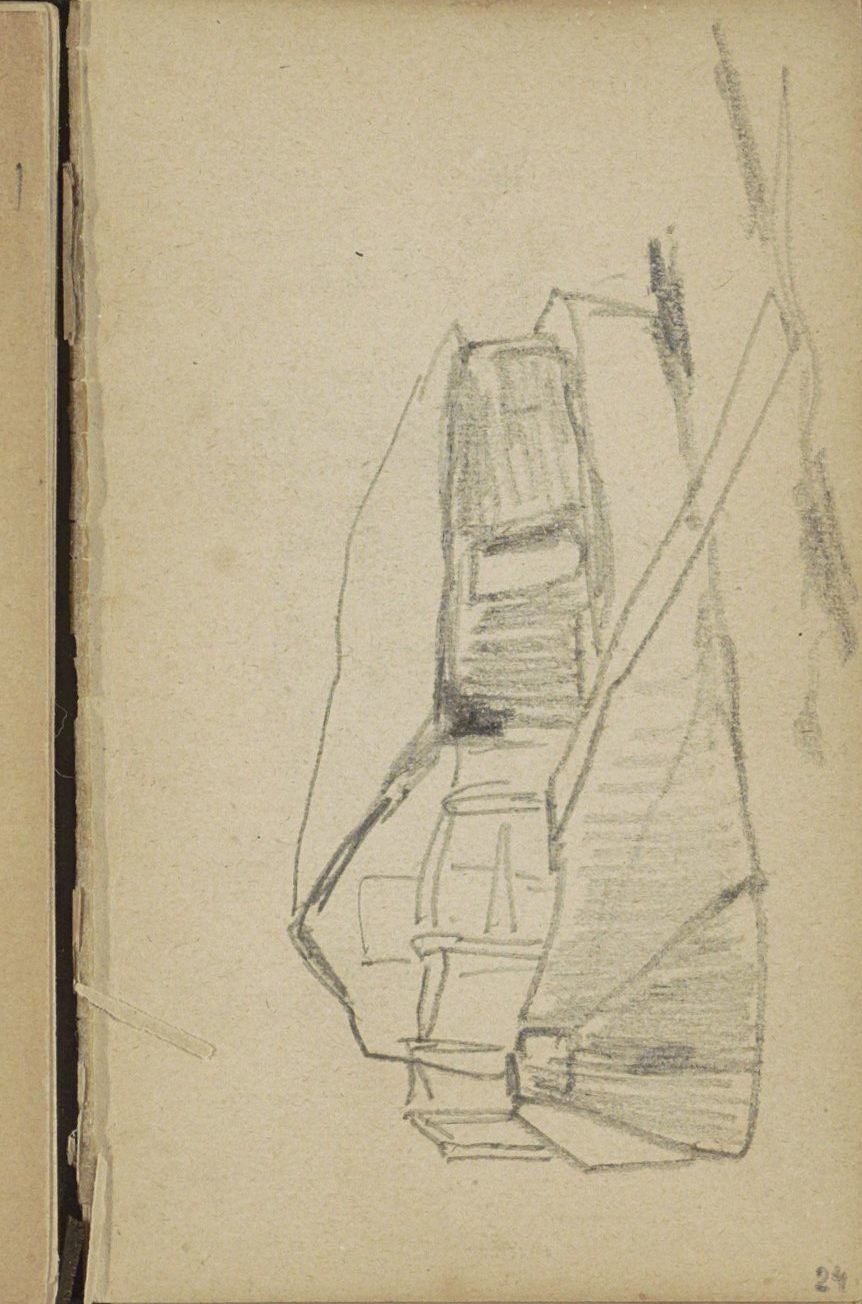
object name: sketchbook leaf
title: Boot met een kajuit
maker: johan hendrik weissenbruch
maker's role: draughtsman, painter, print maker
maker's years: 1824-1903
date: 1834-1903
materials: paper, pencil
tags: traffic on the water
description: Blad 24 recto uit een schetsboek met 32 bladen.